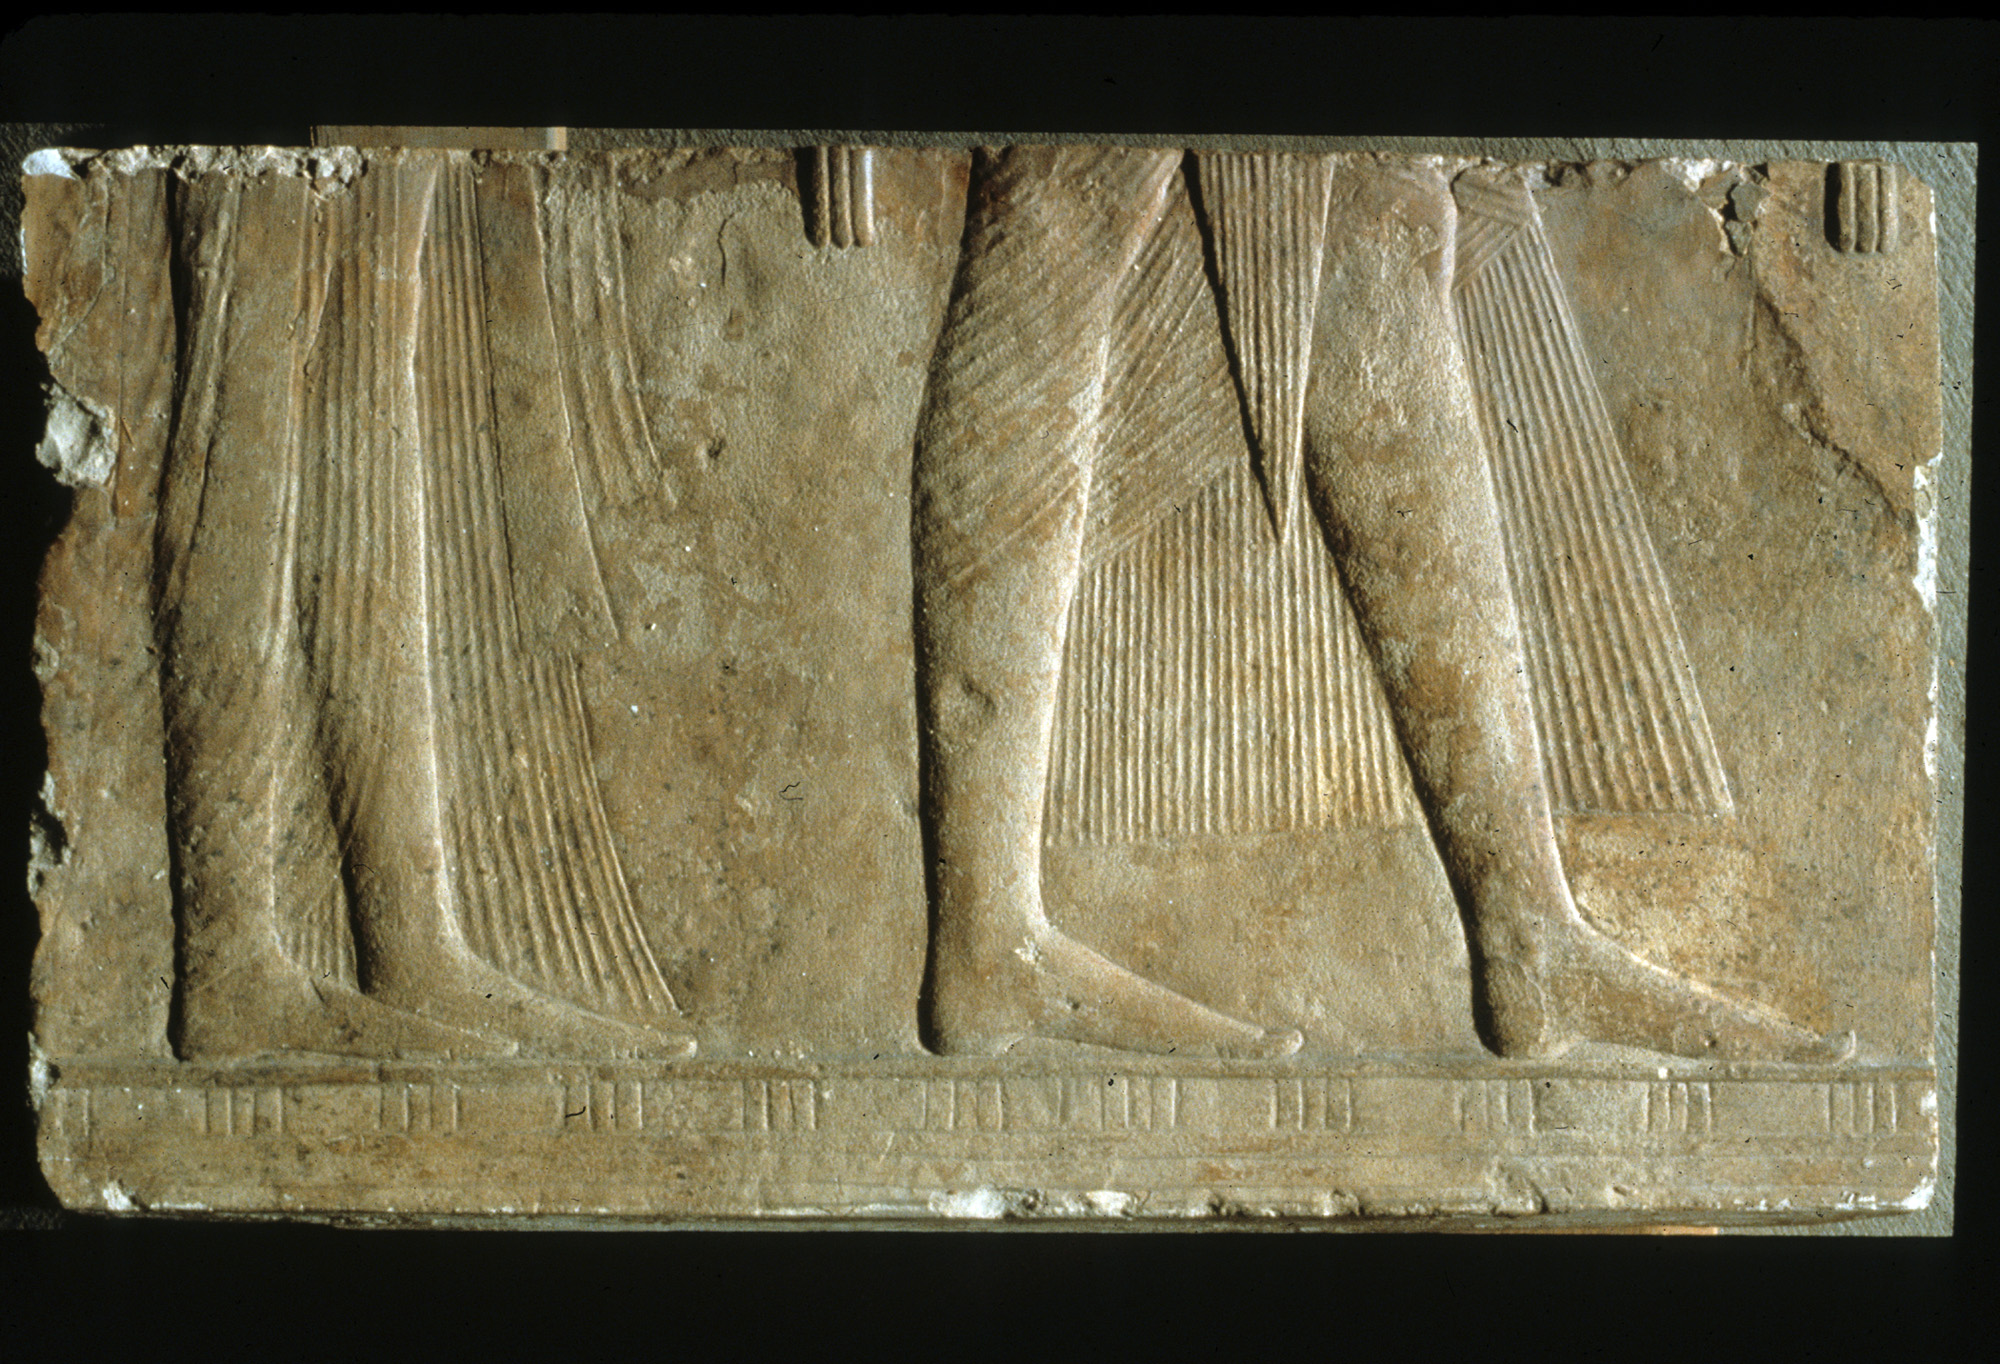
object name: relief, ramesses i chapel, south wall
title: Relief from the South Wall of a Chapel of Ramesses I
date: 1295-1294 BCE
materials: limestone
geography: egypt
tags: feet